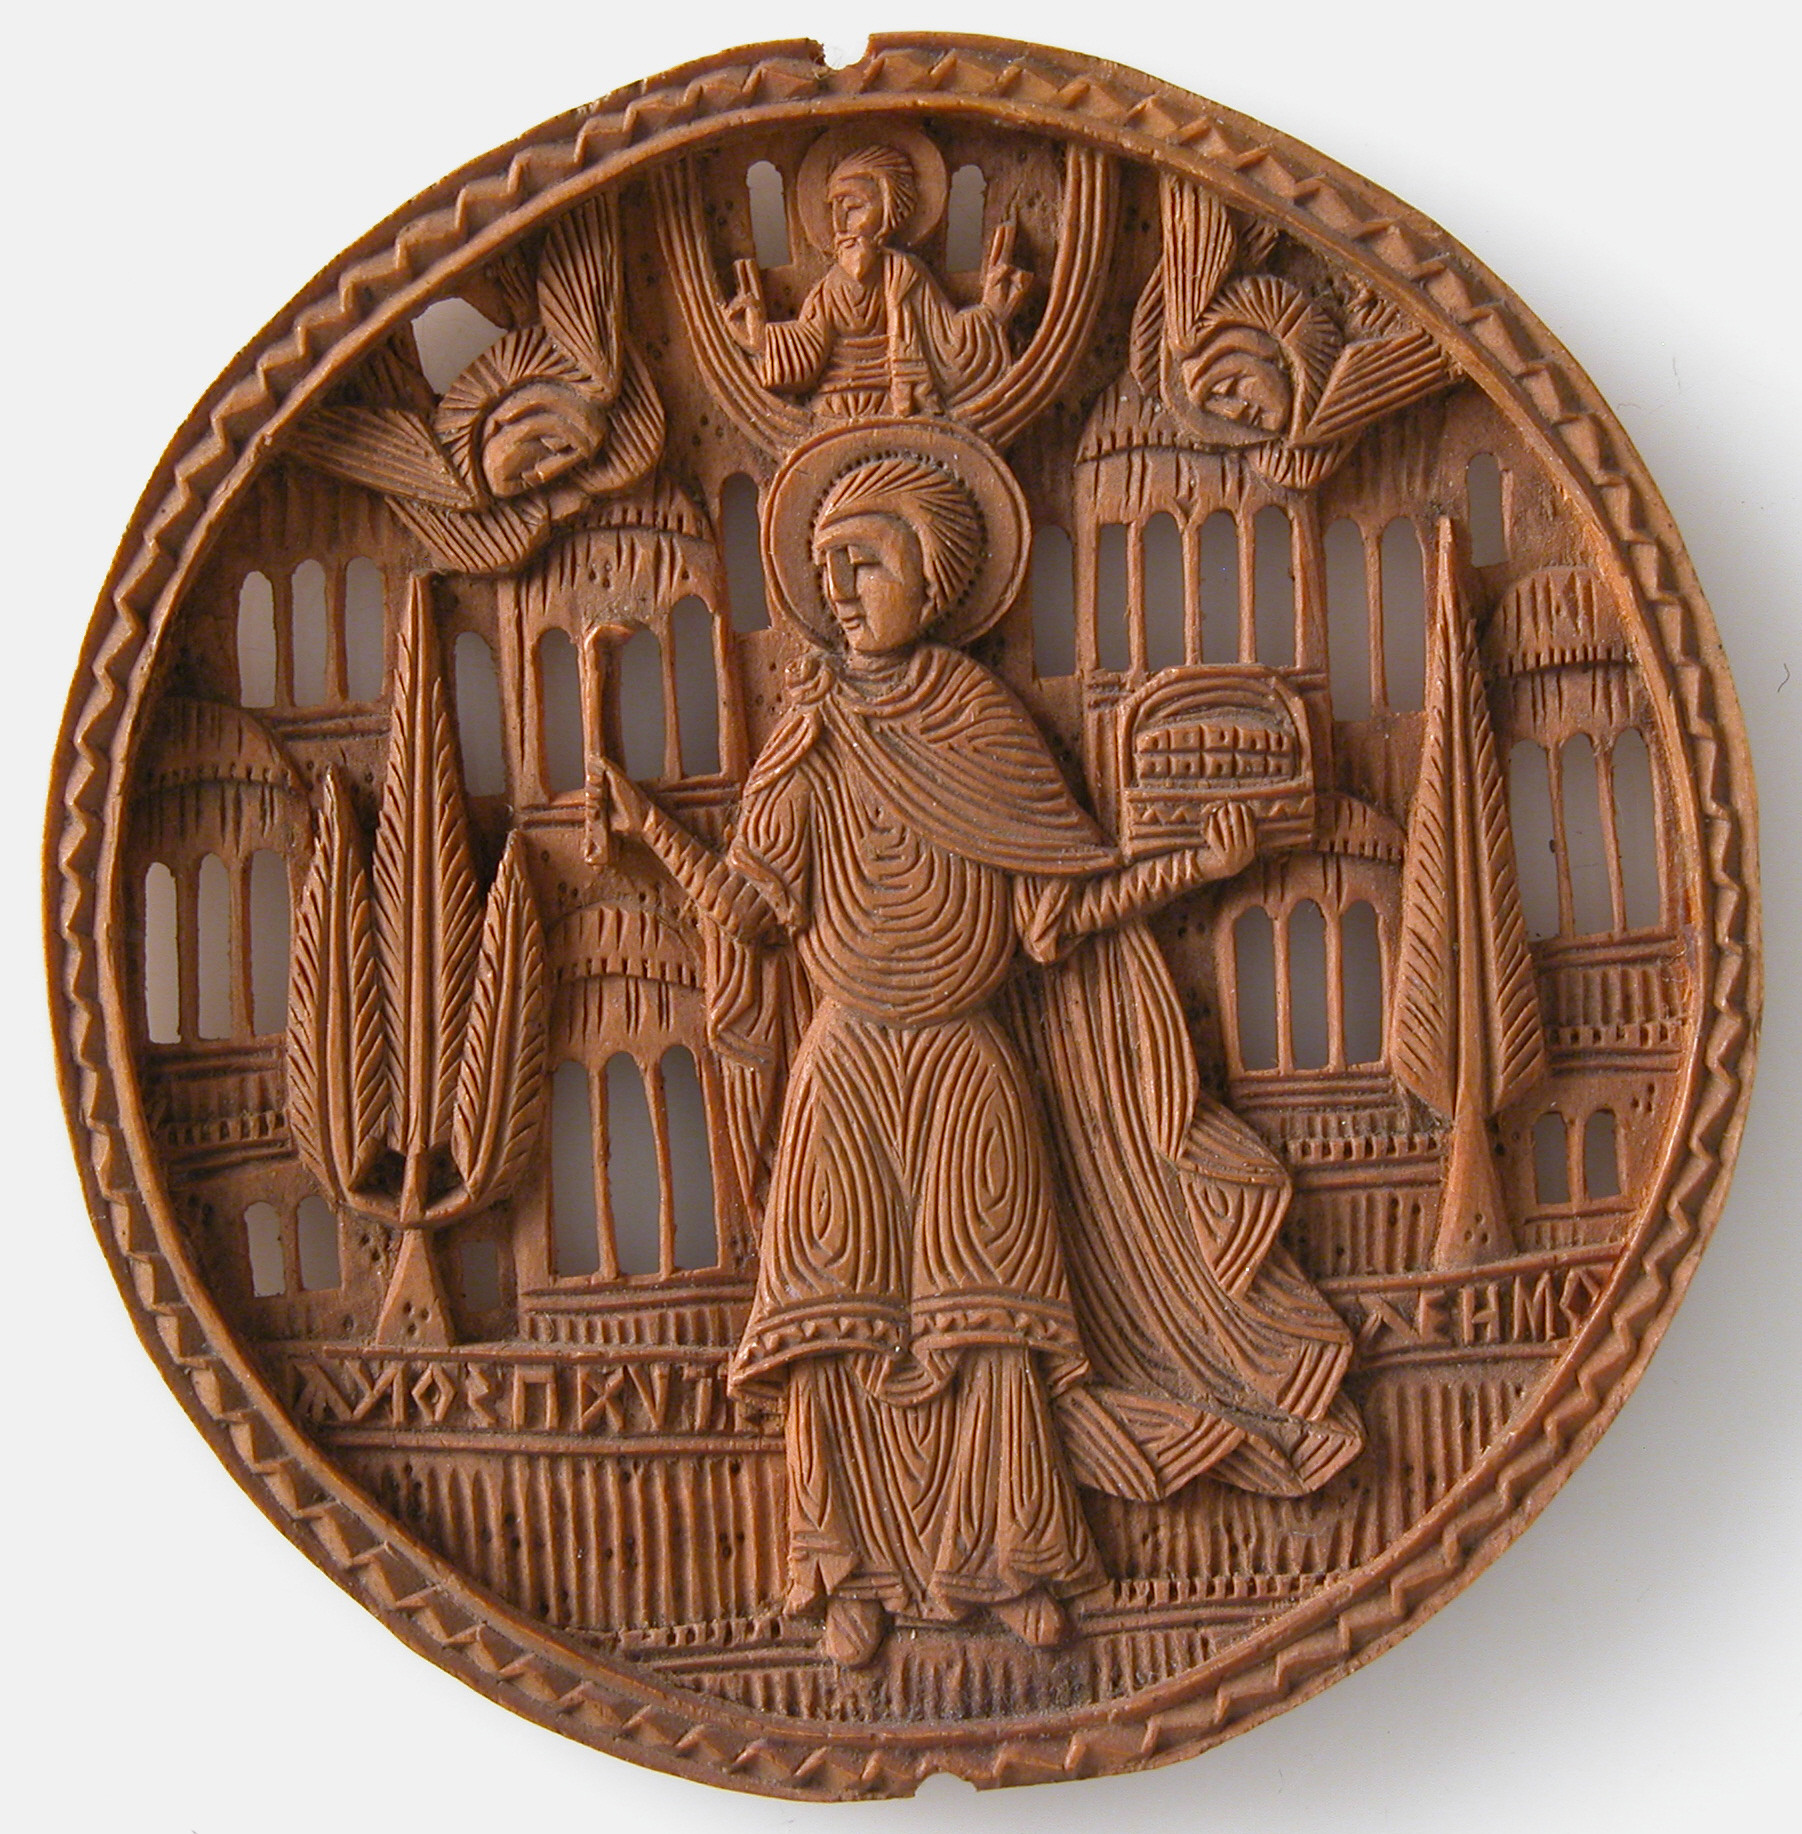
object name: medallion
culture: european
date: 1601-1700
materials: wood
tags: angels,saints,god the father